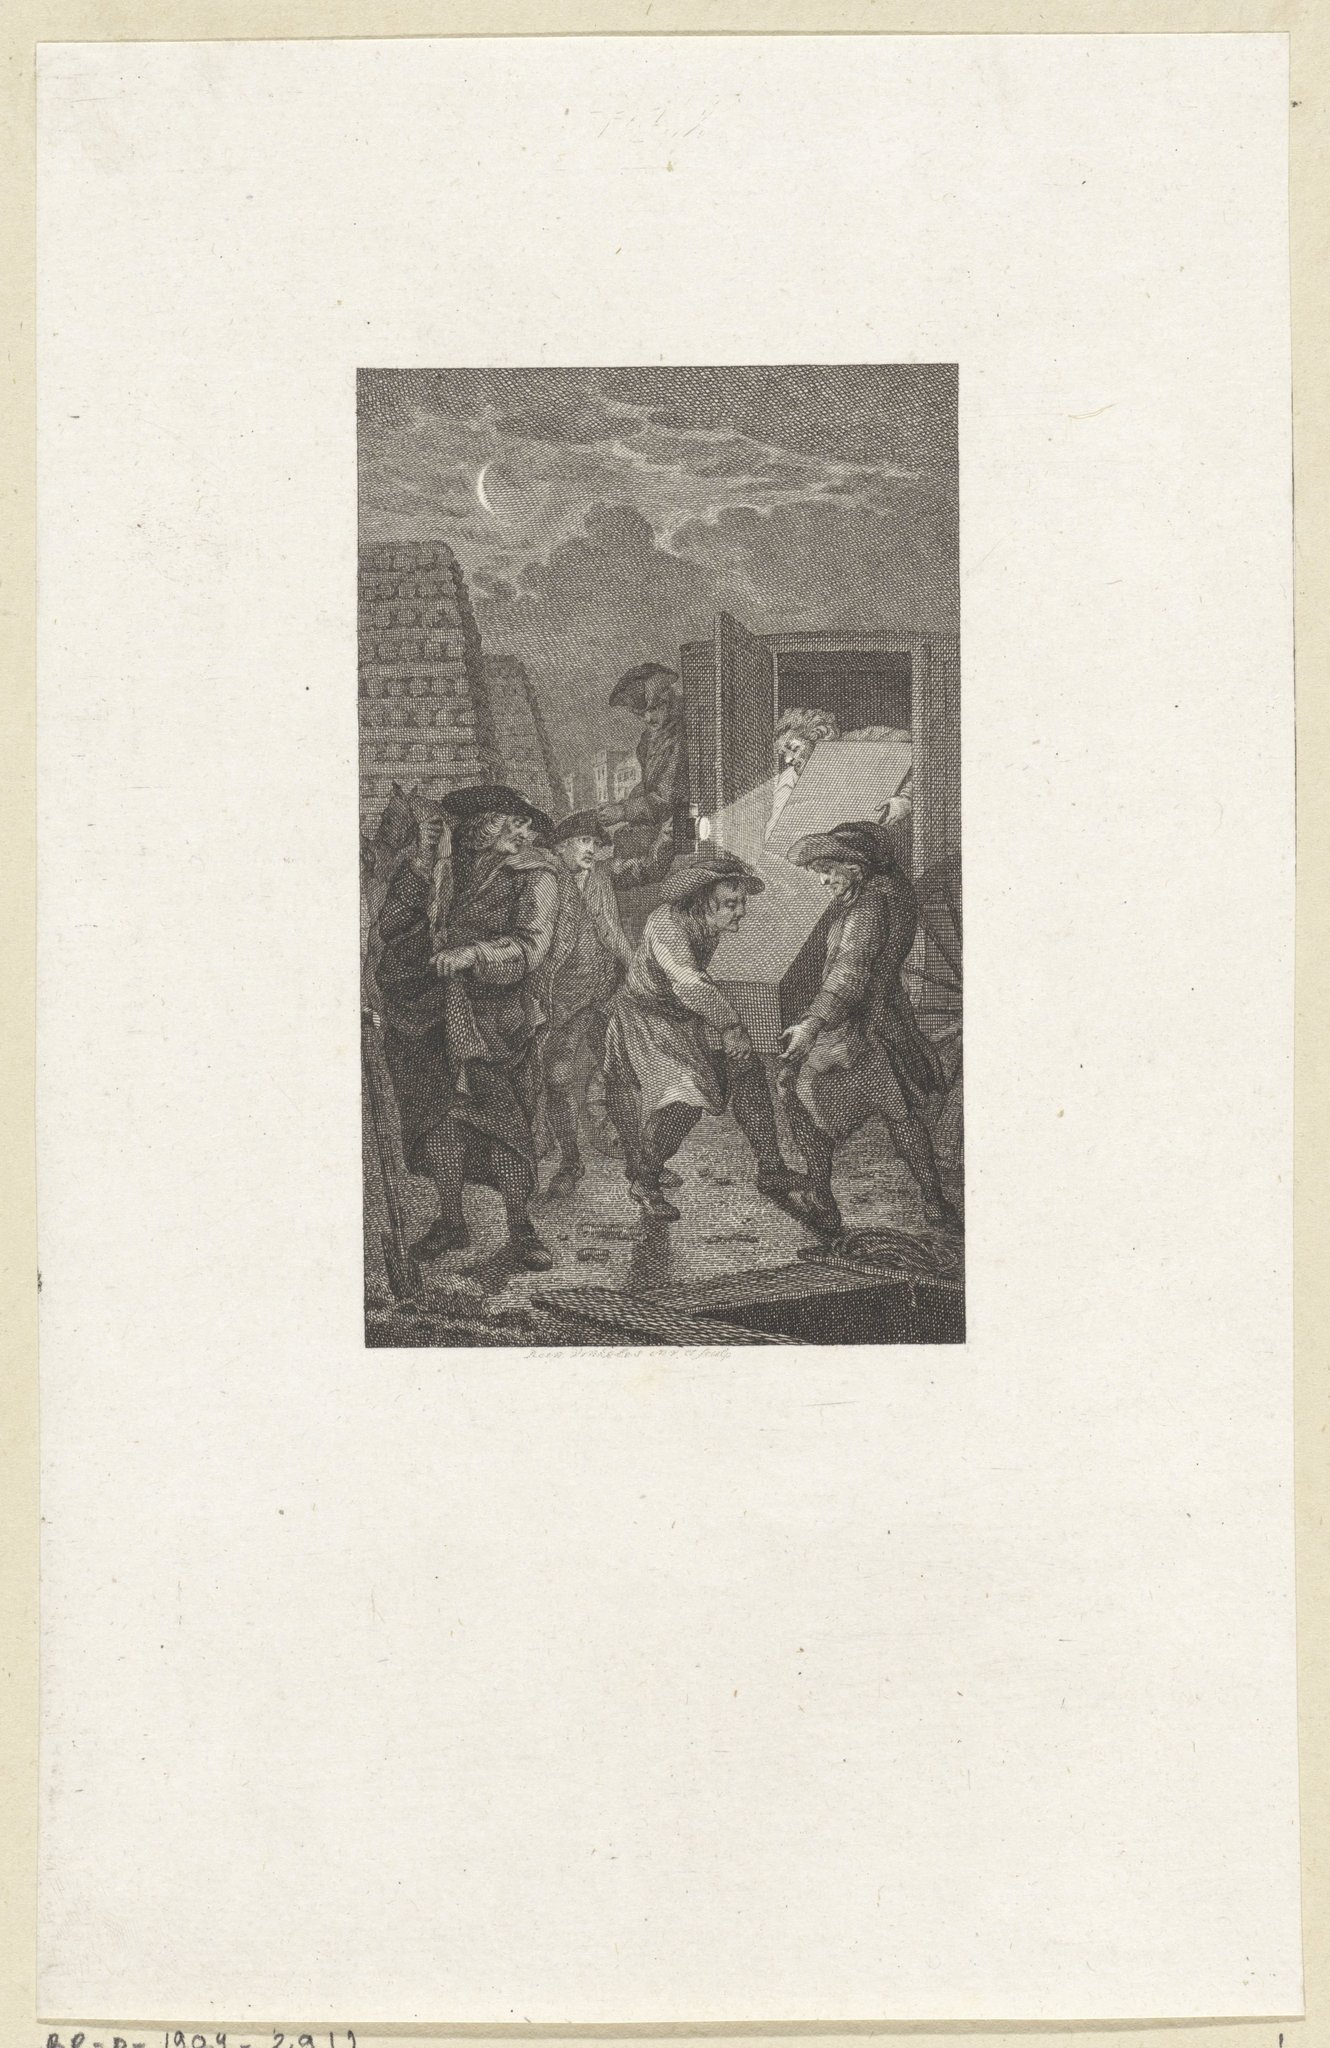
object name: print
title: Nachtgezicht met mannen die een doodskist vervoeren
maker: reinier vinkeles (i)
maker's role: draughtsman, print maker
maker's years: 1741-1816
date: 1785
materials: paper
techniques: engraving, etching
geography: amsterdam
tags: coffin, night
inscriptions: collector's mark: Lugt 2228